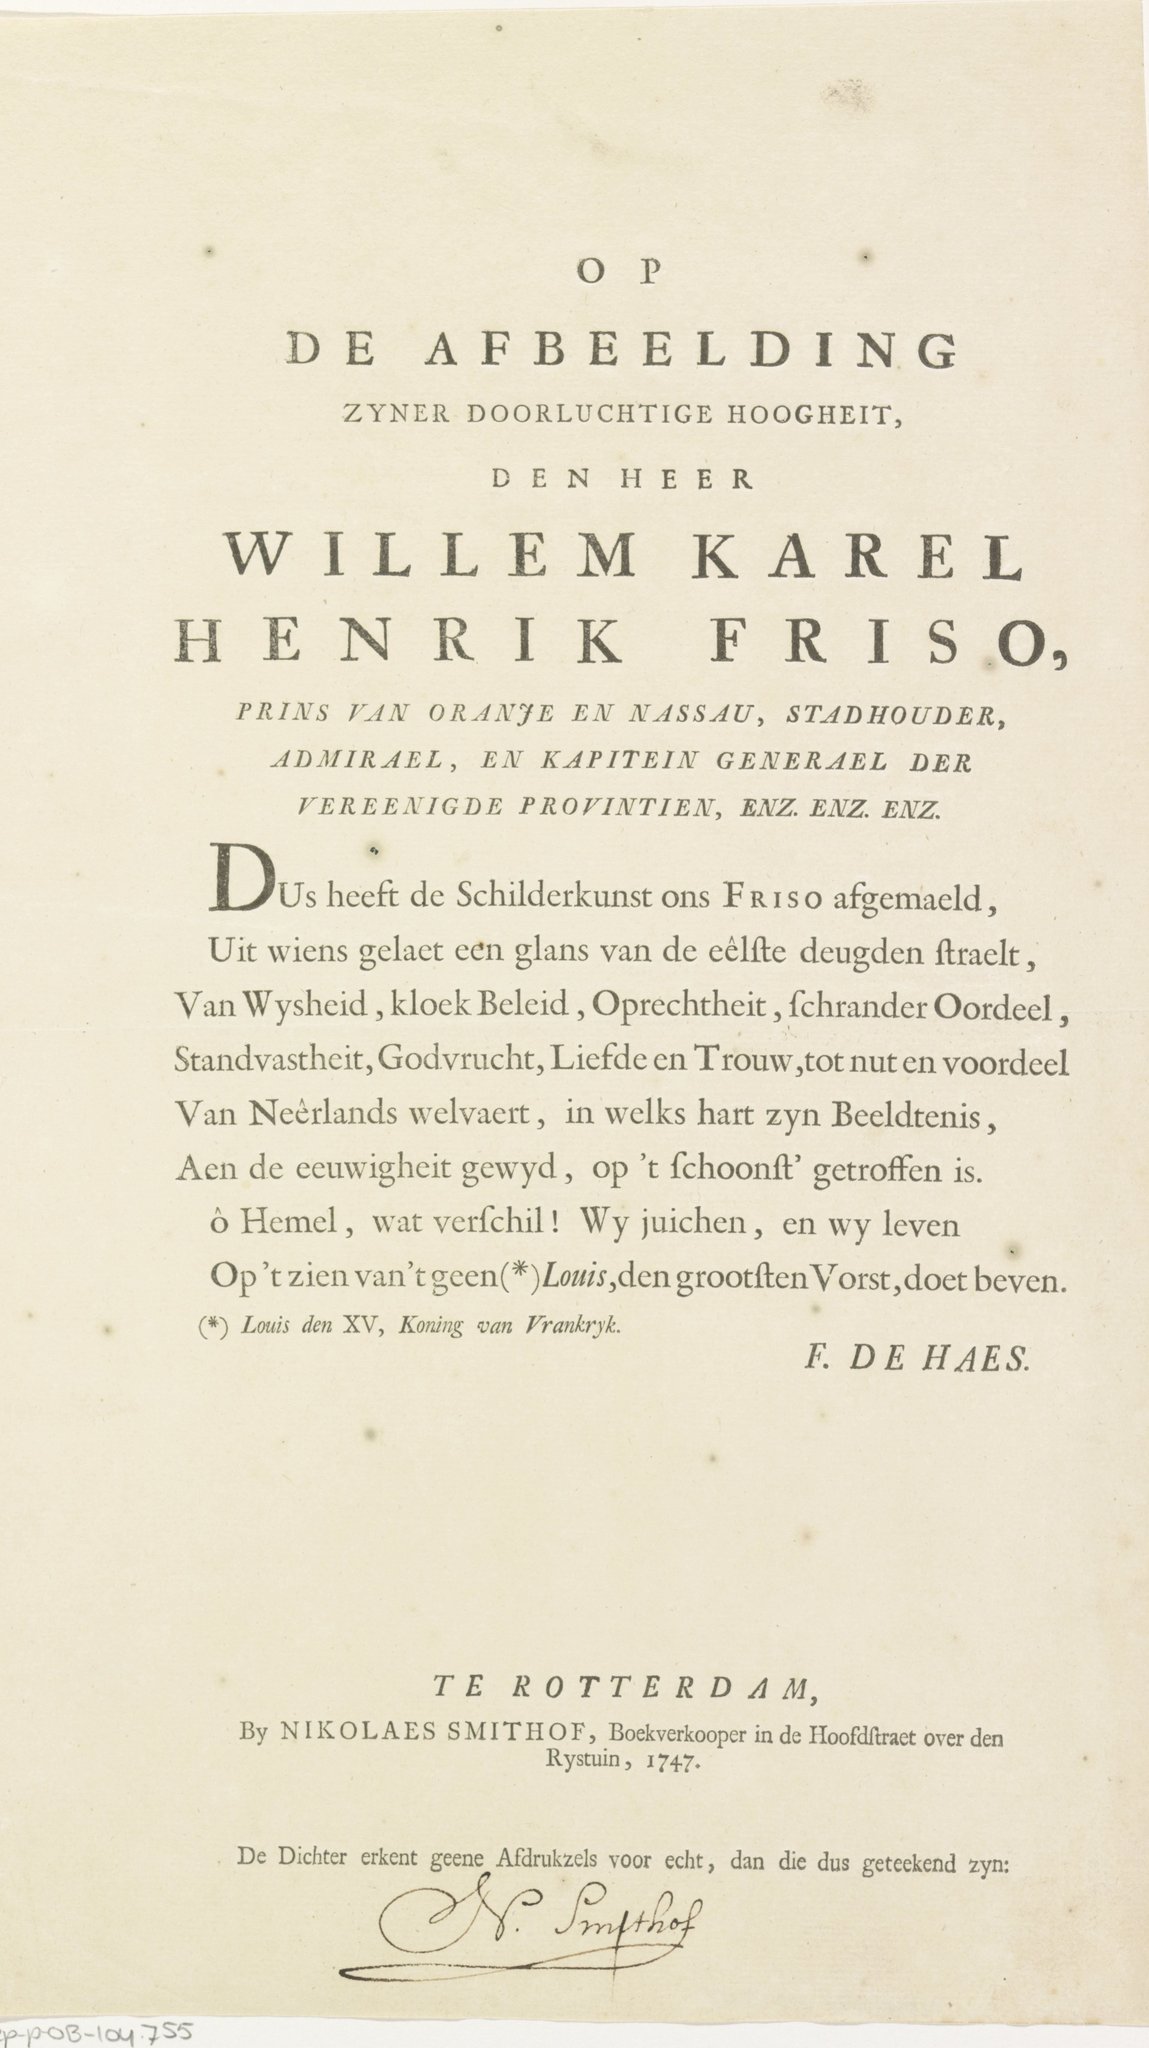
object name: text sheet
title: Tekst bij het portret van Willem IV, prins van Oranje-Nassau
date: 1747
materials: paper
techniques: letterpress printing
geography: rotterdam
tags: the hague, willem iv (prins van oranje-nassau)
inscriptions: inscription: ‘N. Smithof’, collector's mark: Lugt 2228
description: De hier vermelde titel verwijst naar de hoogst verkregen titel van de geportretteerde, niet per se naar de titel die de geportretteerde op deze voorstelling draagt.